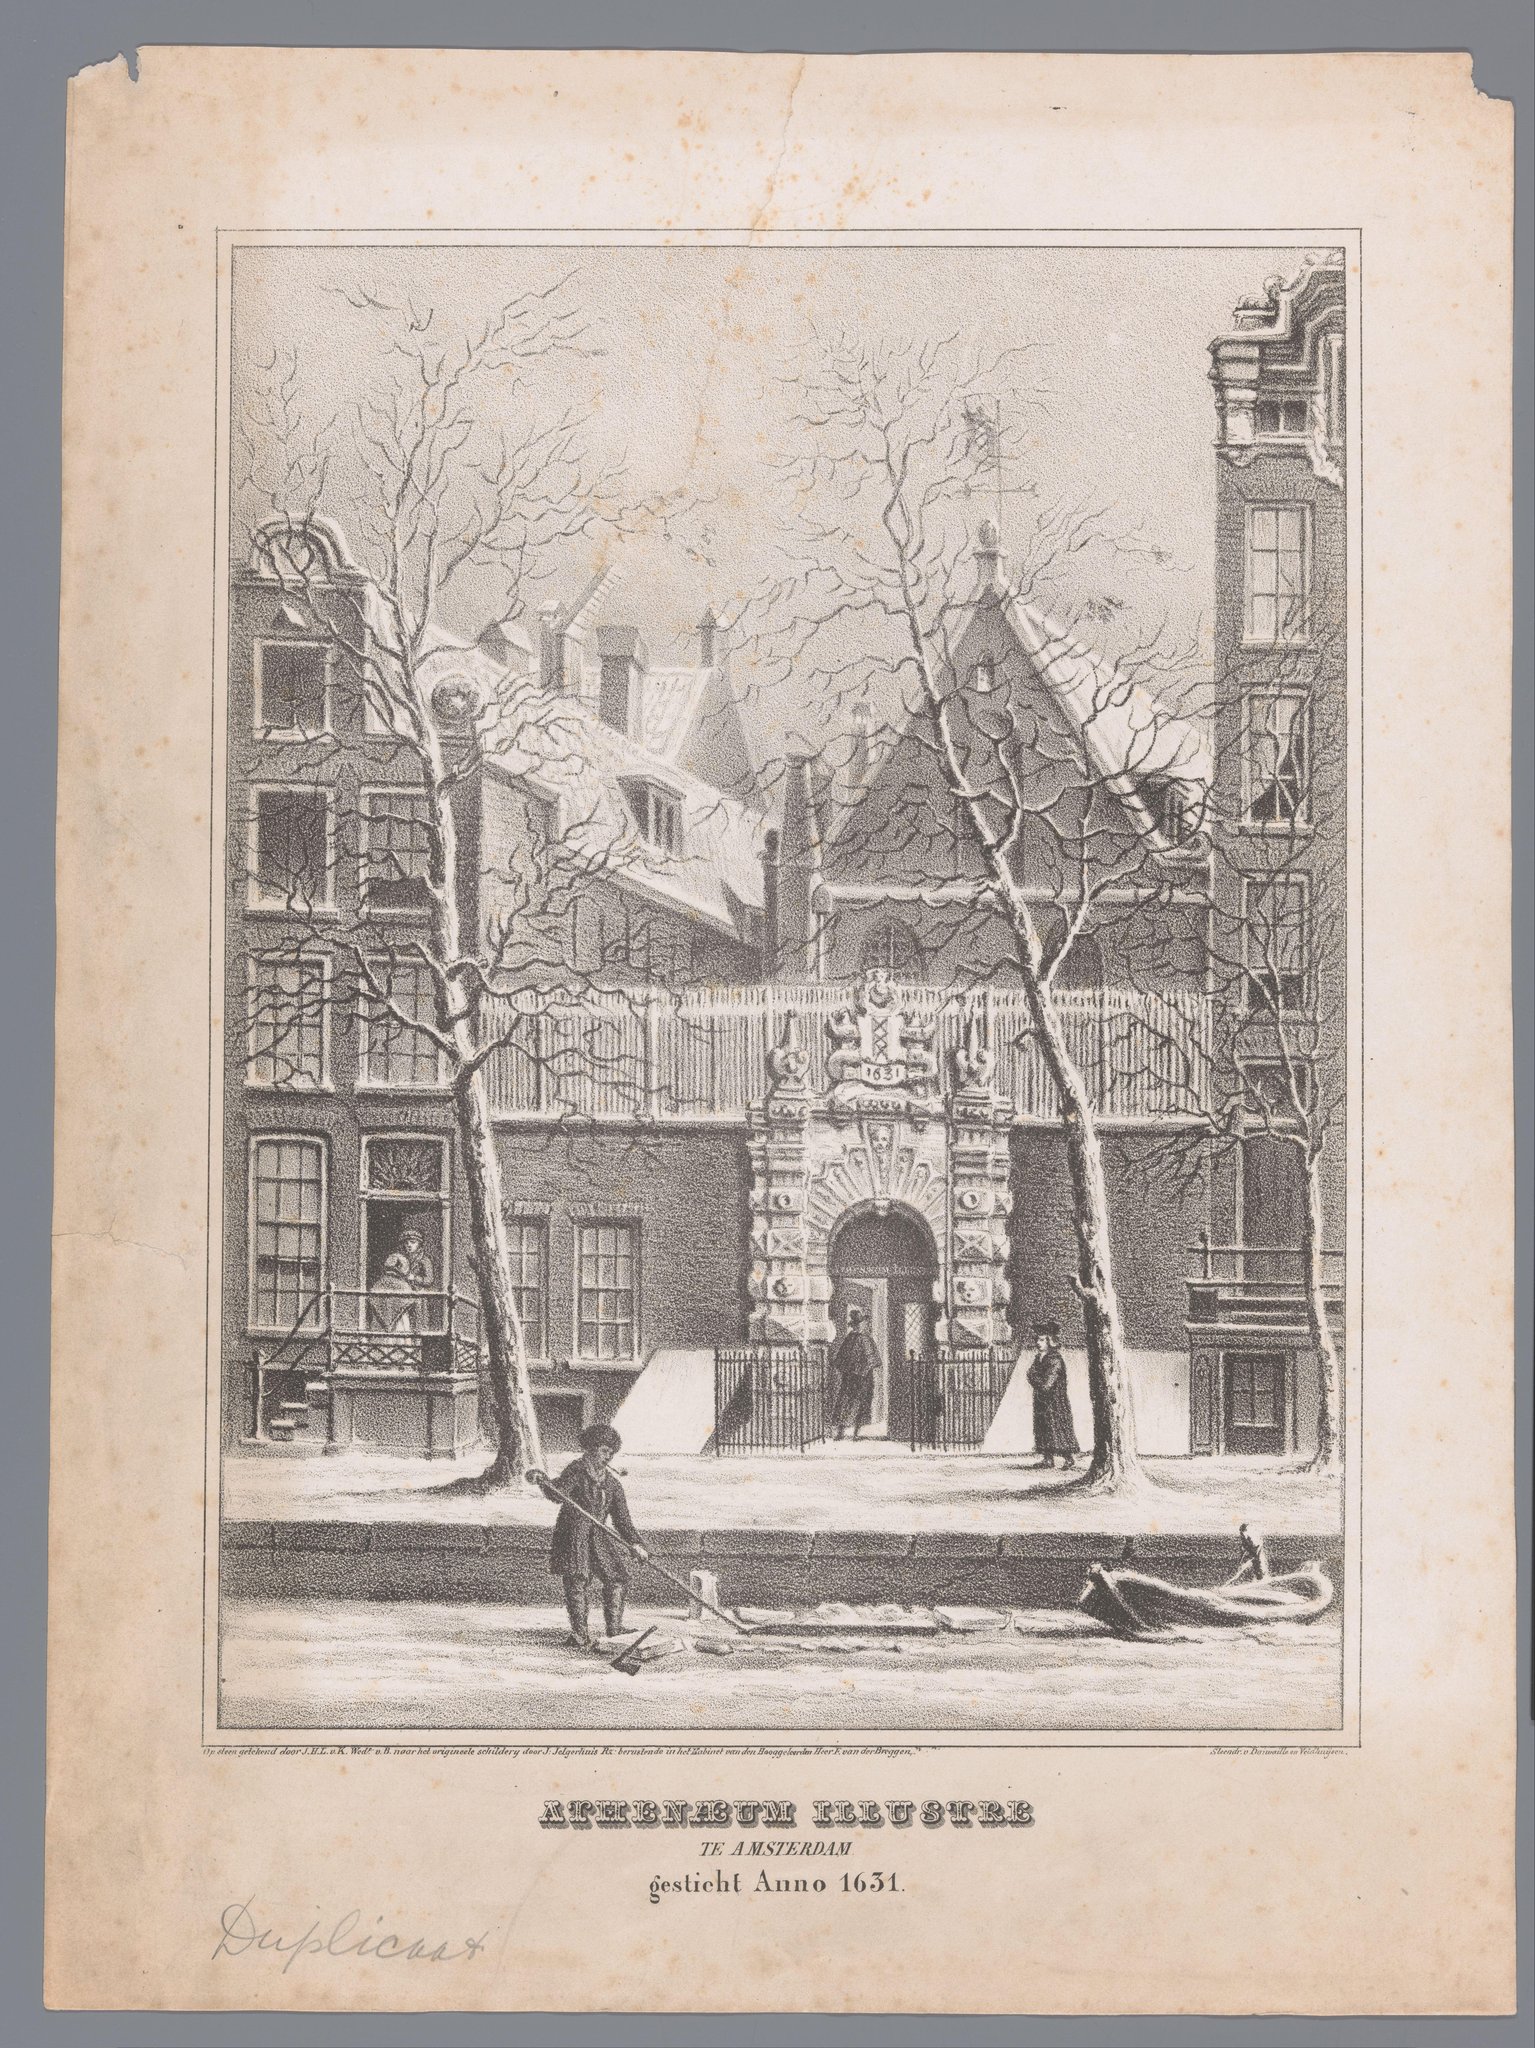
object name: print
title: Athenaeum Illustre te Amsterdam gesticht Anno 1631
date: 1832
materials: paper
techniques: lithograph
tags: names of organizations, companies, trade unions, etc., canals, waters (in city), university building, college, ice ~ state of water